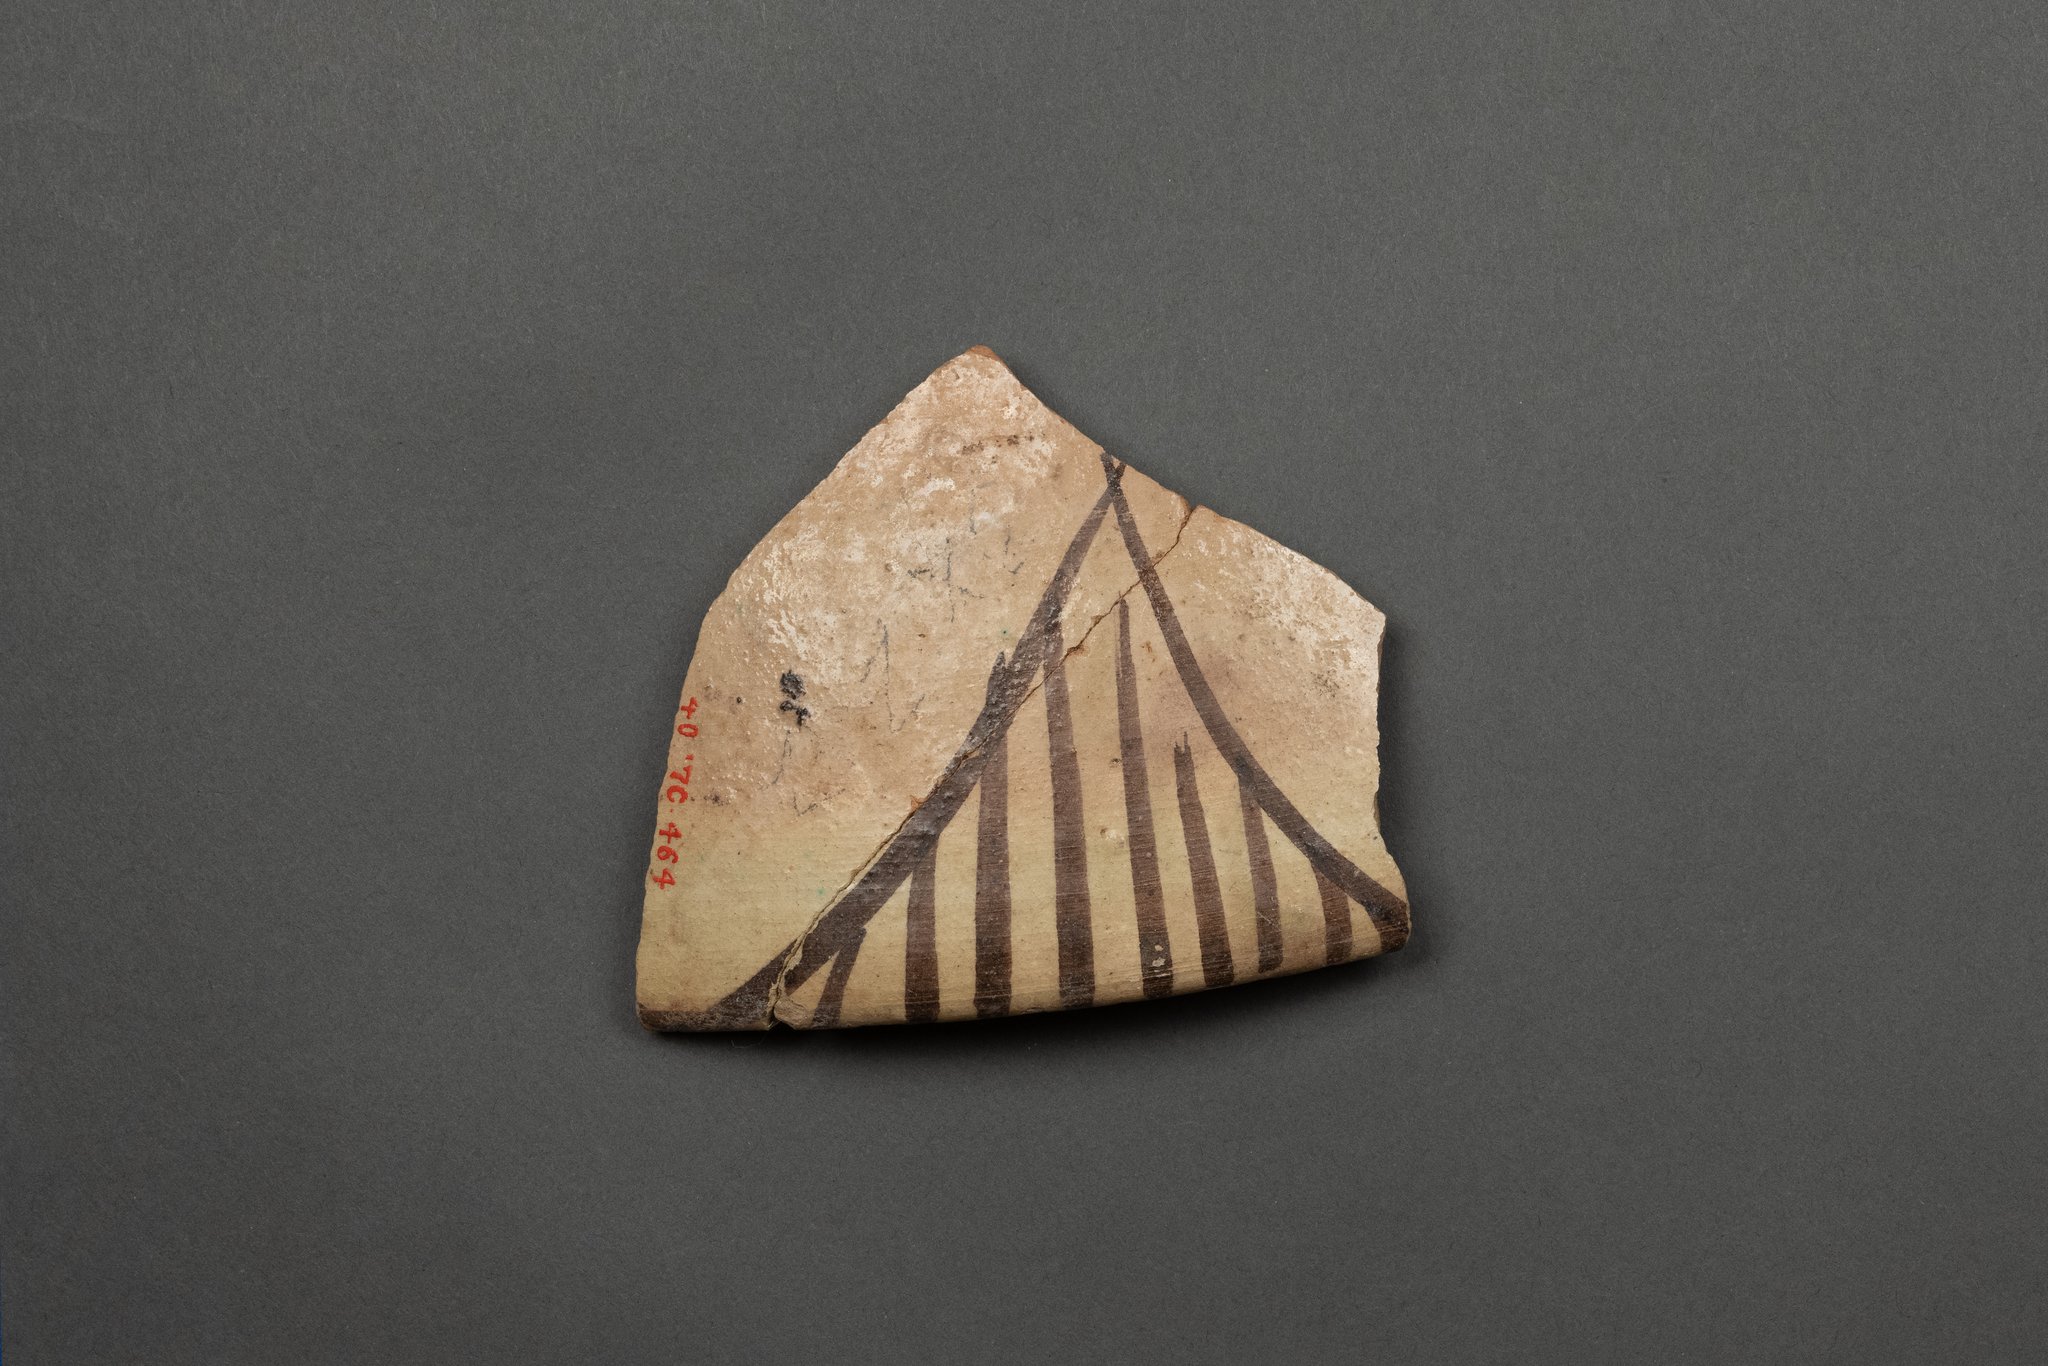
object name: fragment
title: Fragment of a Bowl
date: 801-900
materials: earthenware, glaze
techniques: incising, polychrome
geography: iran